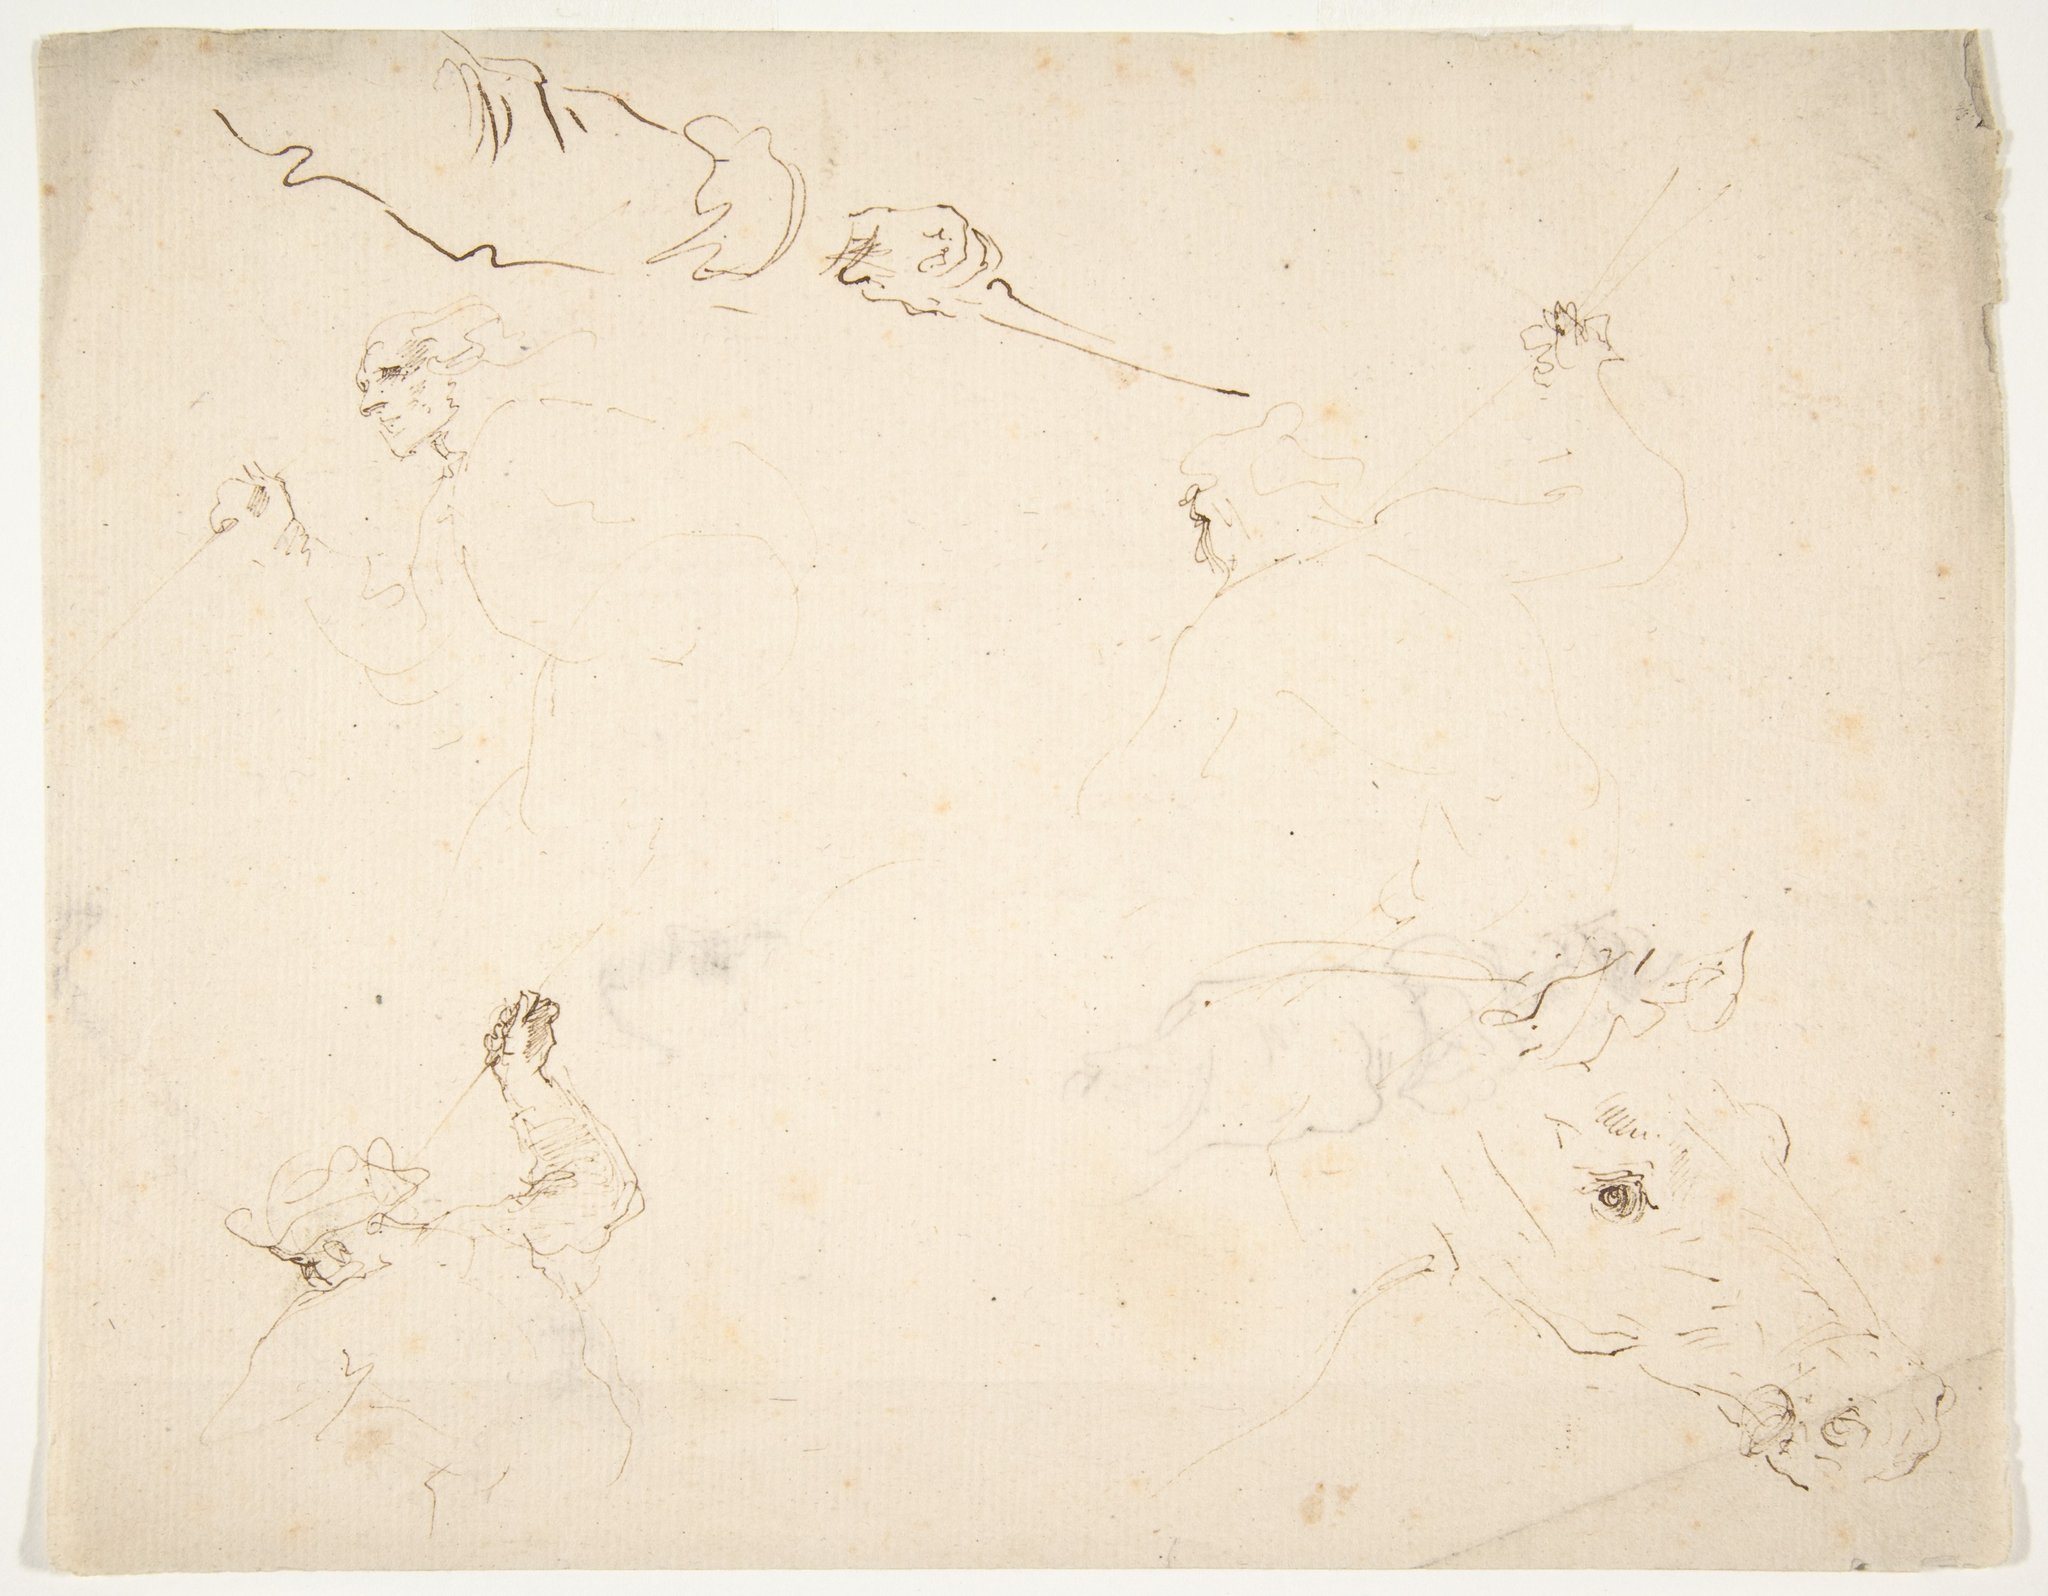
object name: drawing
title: Figures in Battle and Head of a Horse (recto); Studies of a Man's Head and Arms (verso)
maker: stefano della bella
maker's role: artist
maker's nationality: italian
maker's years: 1610-1664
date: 1610-1664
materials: ink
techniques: pen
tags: heads,men,horses